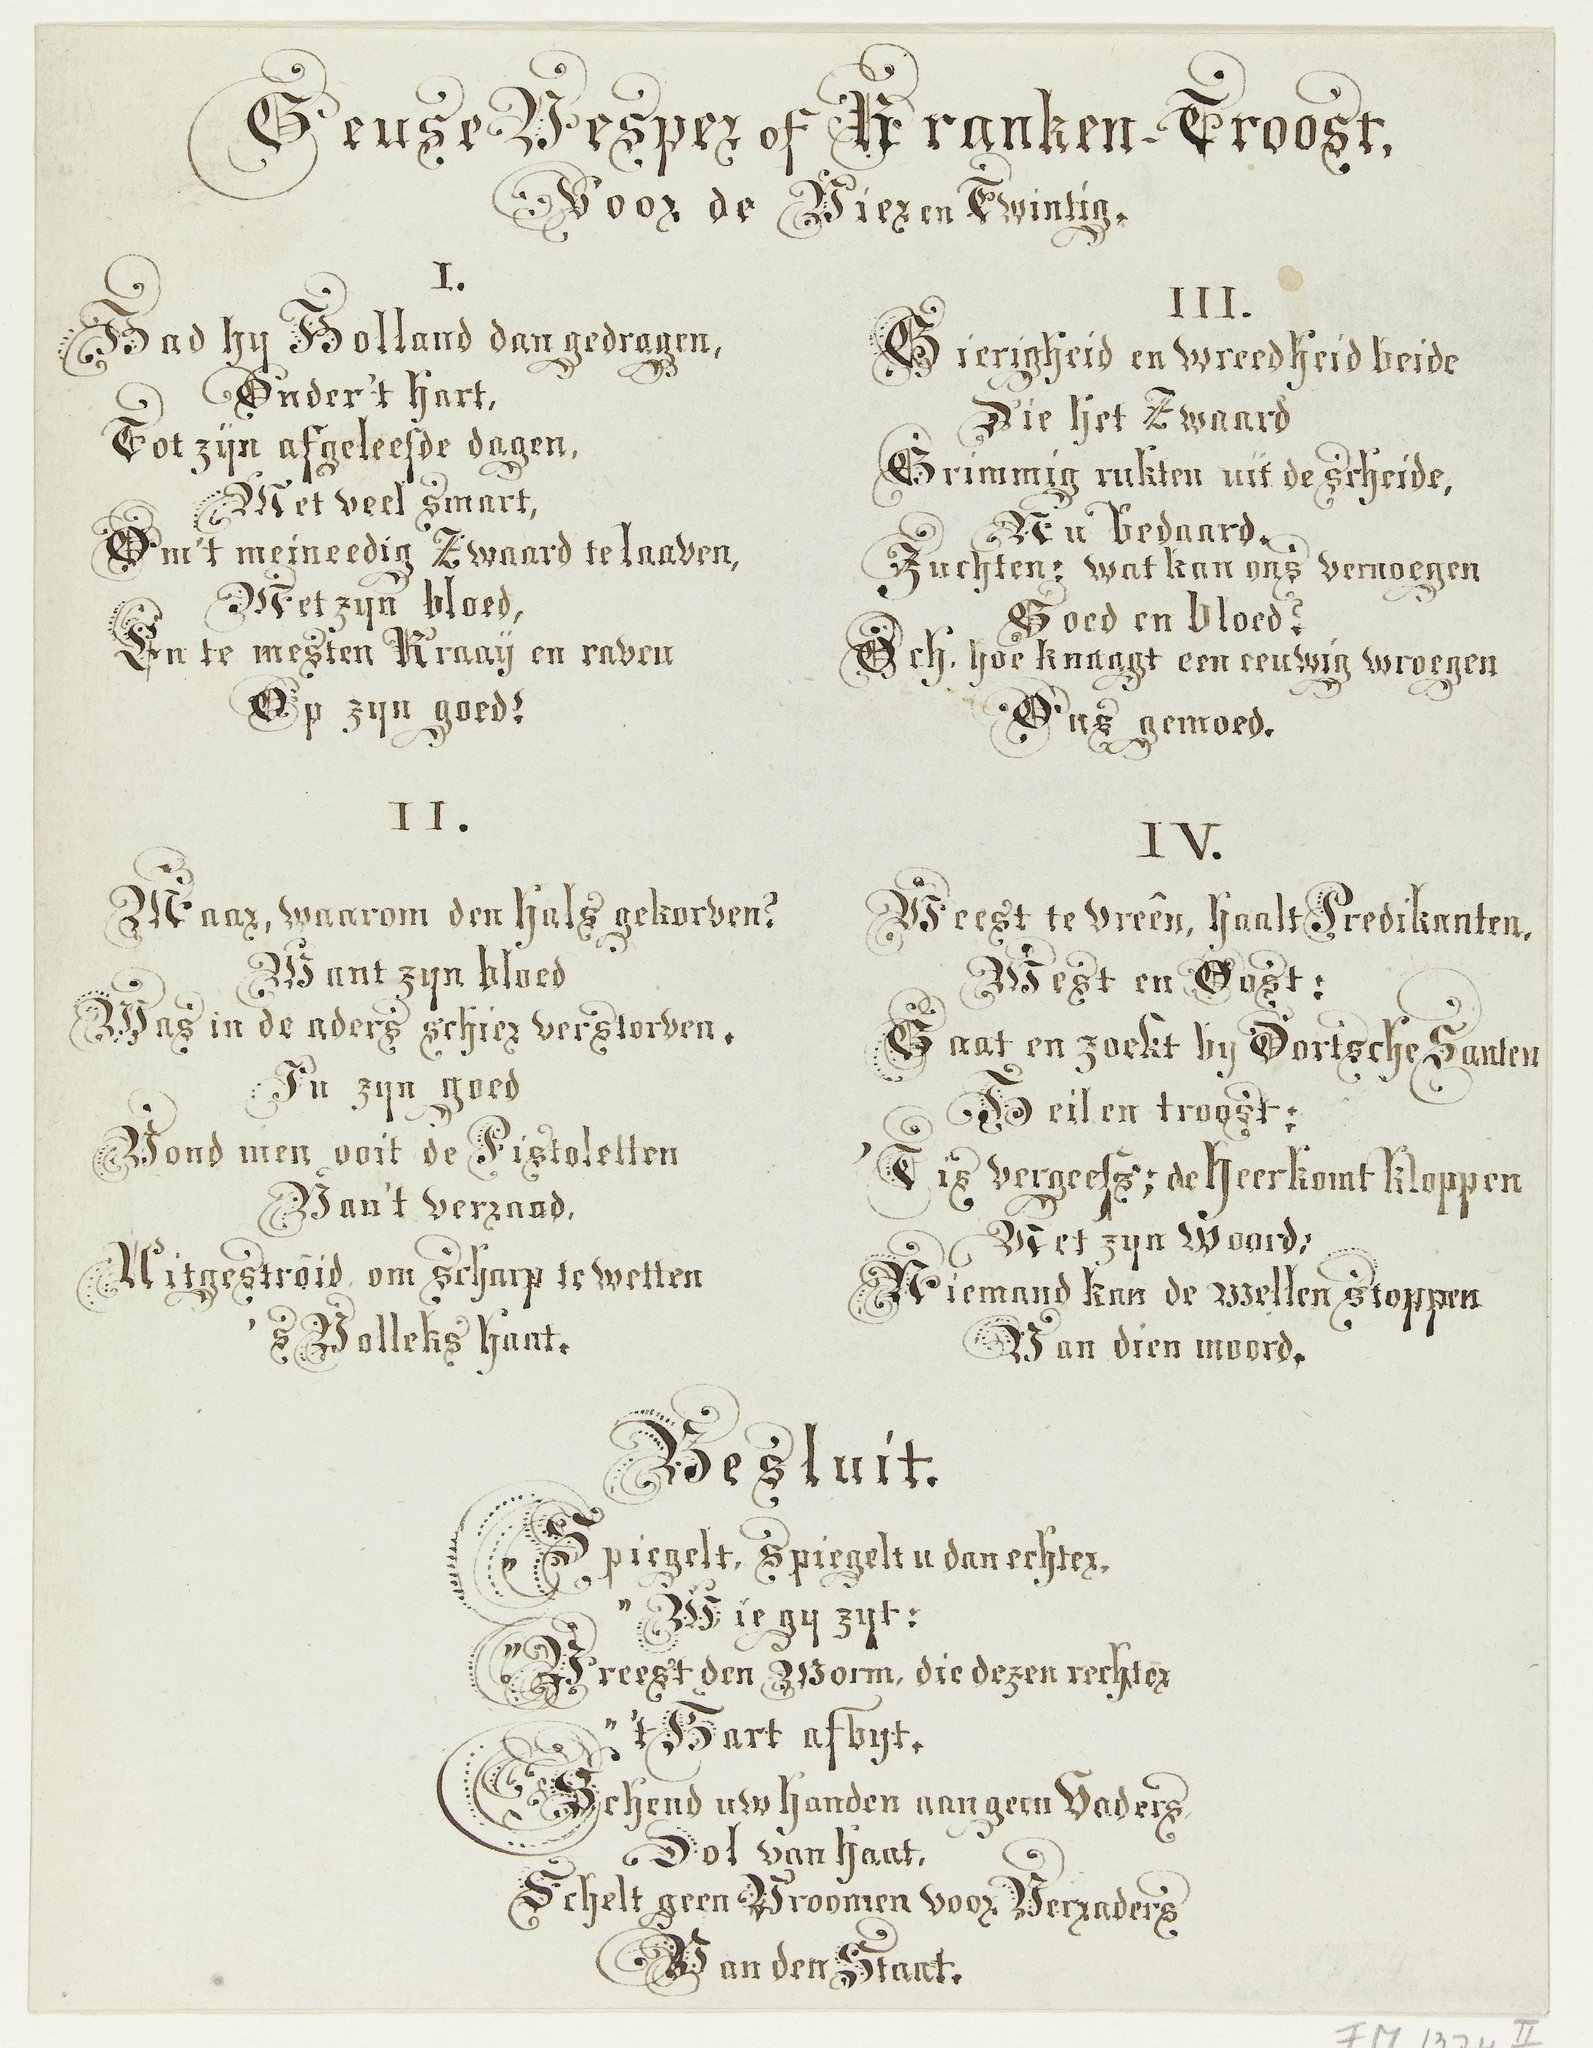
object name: manuscript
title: Spotvers op de 24 rechters die Johan van Oldenbarnevelt hebben veroordeeld, 1619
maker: joost van den vondel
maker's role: dichter, toneelschrijver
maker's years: 1587-1679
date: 1800-1899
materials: ink, paper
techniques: pen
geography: netherlands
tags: johan van oldenbarnevelt, letters, alphabet, script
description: Spotvers op de 24 rechters die Johan van Oldenbarnevelt hebben veroordeeld, februari 1619. Vers in 4 coupletten I-IV en eindigend met een Besluit.